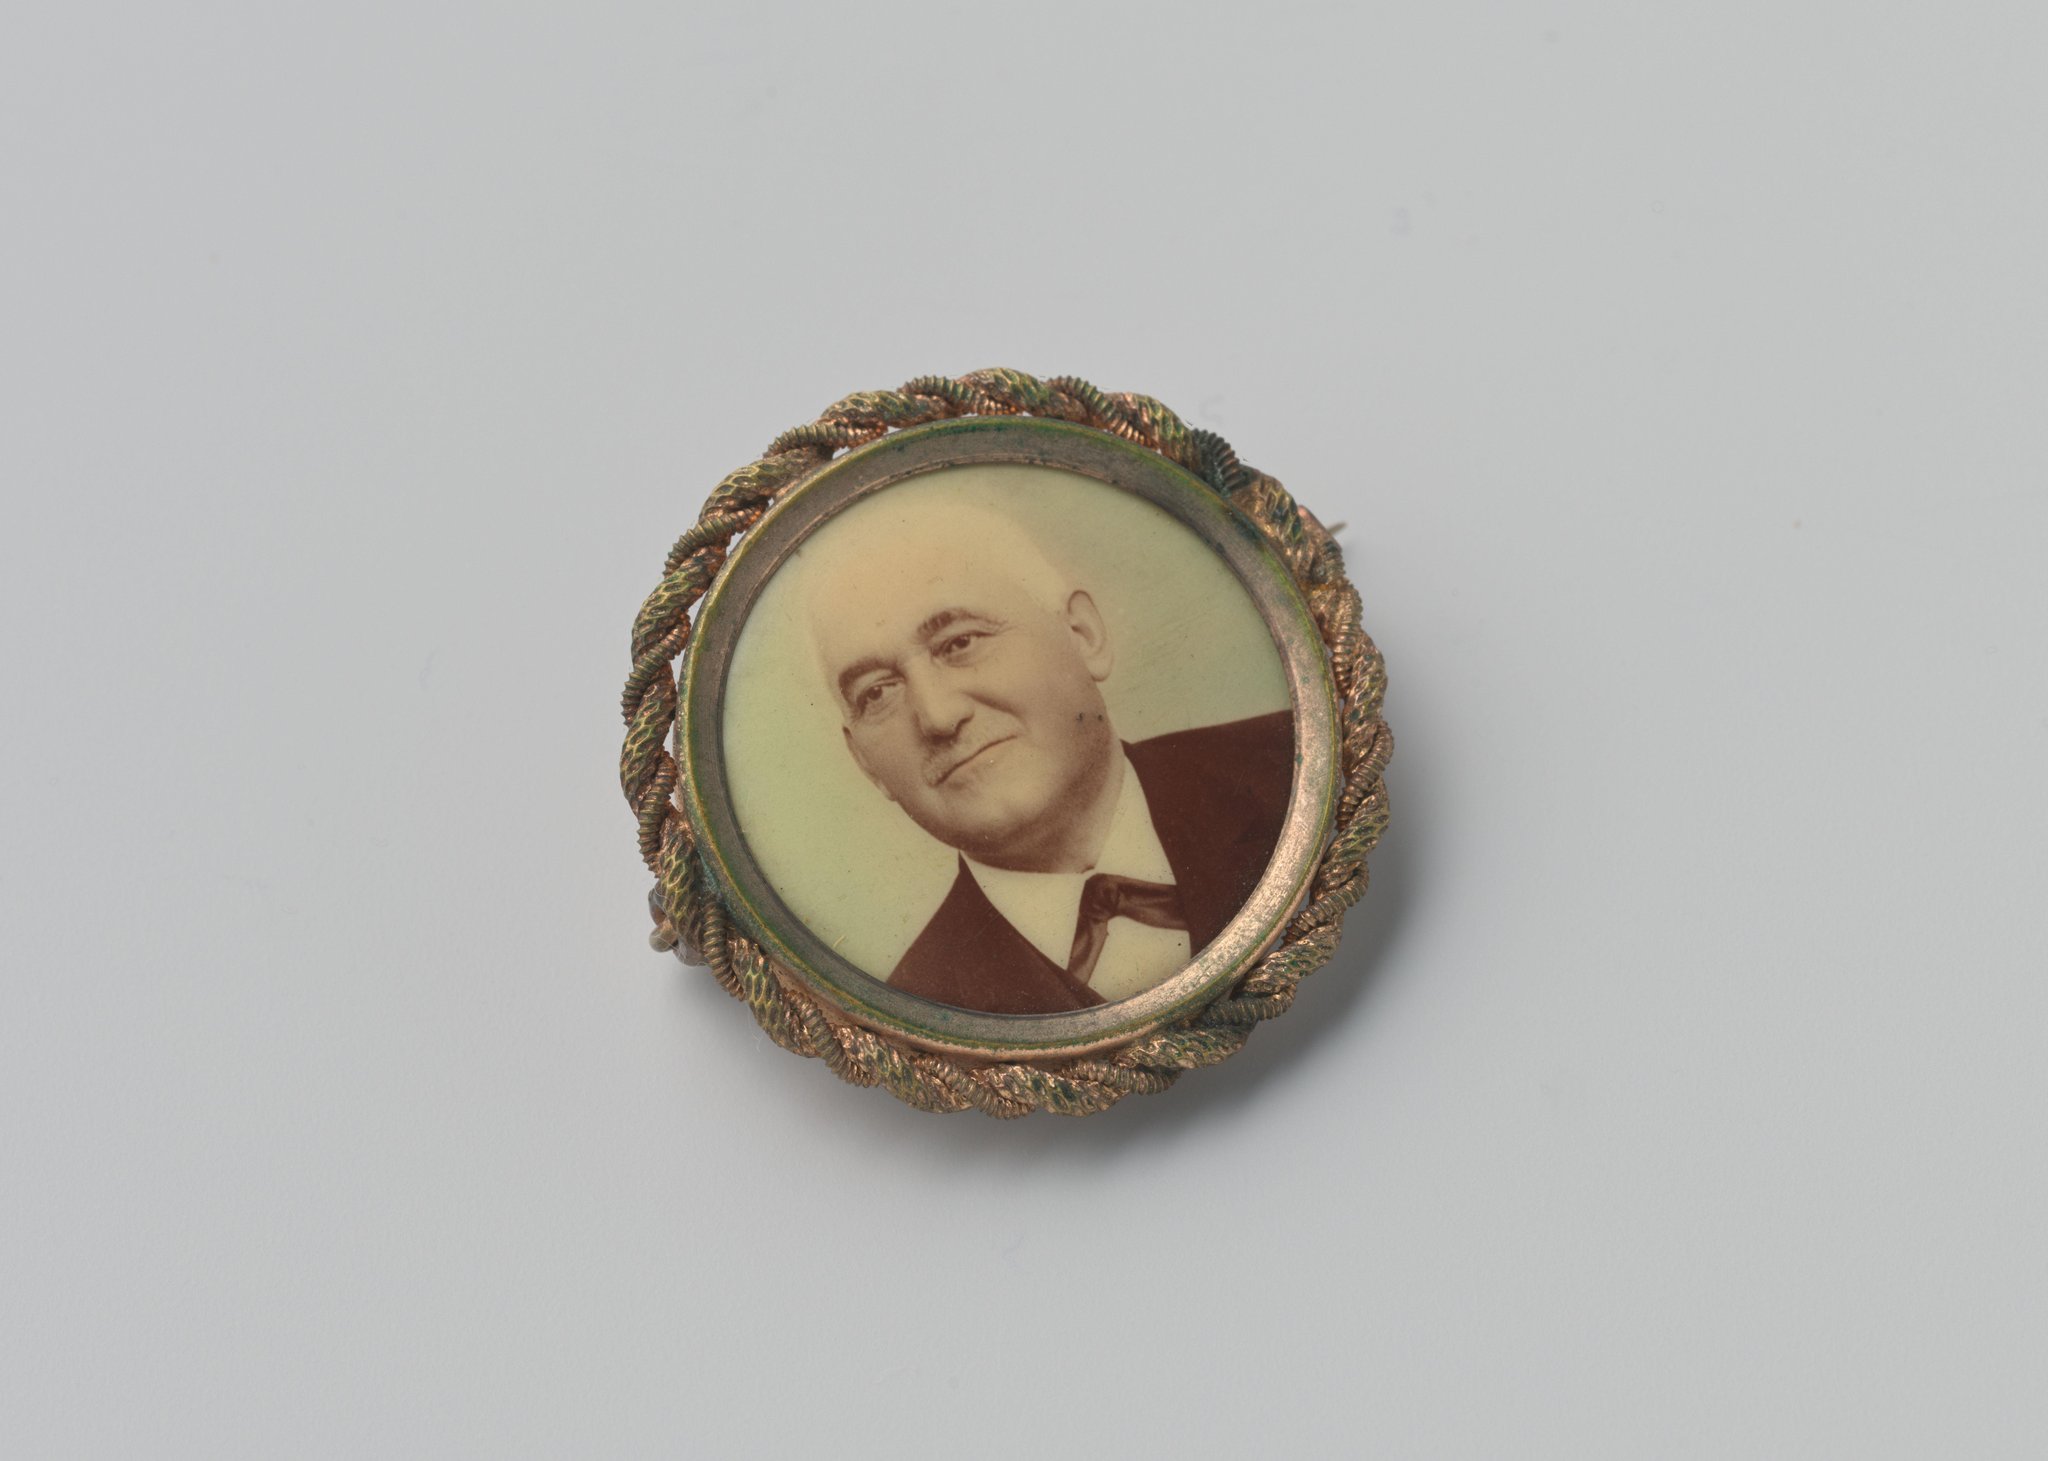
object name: photograph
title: Foto van een oudere heer, gevat in een ronde broche van metaal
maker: Anonymous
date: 1900-1925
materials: metal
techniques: photography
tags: eugen wachenheimer, else wachenheimer-moos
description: Dit object is onderdeel van de nalatenschap van Isabel Elon-Wachenheimer (1928-2010). Tot haar overlijden behoorde het samen met de andere objecten uit de nalatenschap tot haar privédomein van Isabel Wachenheimer. In die particuliere context zijn deze objecten tezamen en individueel aandenkens - aan de jeugd, ouders en familie van Isabel Wachenheimer vóór en tijdens de Shoah en aan haar leven na de Tweede Wereldoorlog. Isabel Wachenheimer, die van juni 1943 tot mei 1945 gevangen zat in Kamp Westerbork, Theresienstadt, Auschwitz, Lenzing a/d Oberdonau (een buitenkamp van Mauthausen), overleefde de Shoah. Haar ouders – Eugène Wachenheimer en Else Wachenheimer-Moos - werden op 14 oktober 1944 in Auschwitz-Birkenau vermoord.